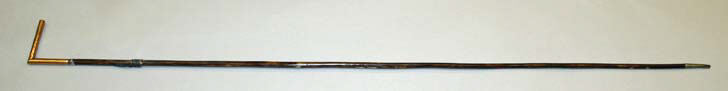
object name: cane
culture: american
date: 1880-1889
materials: gold, wood